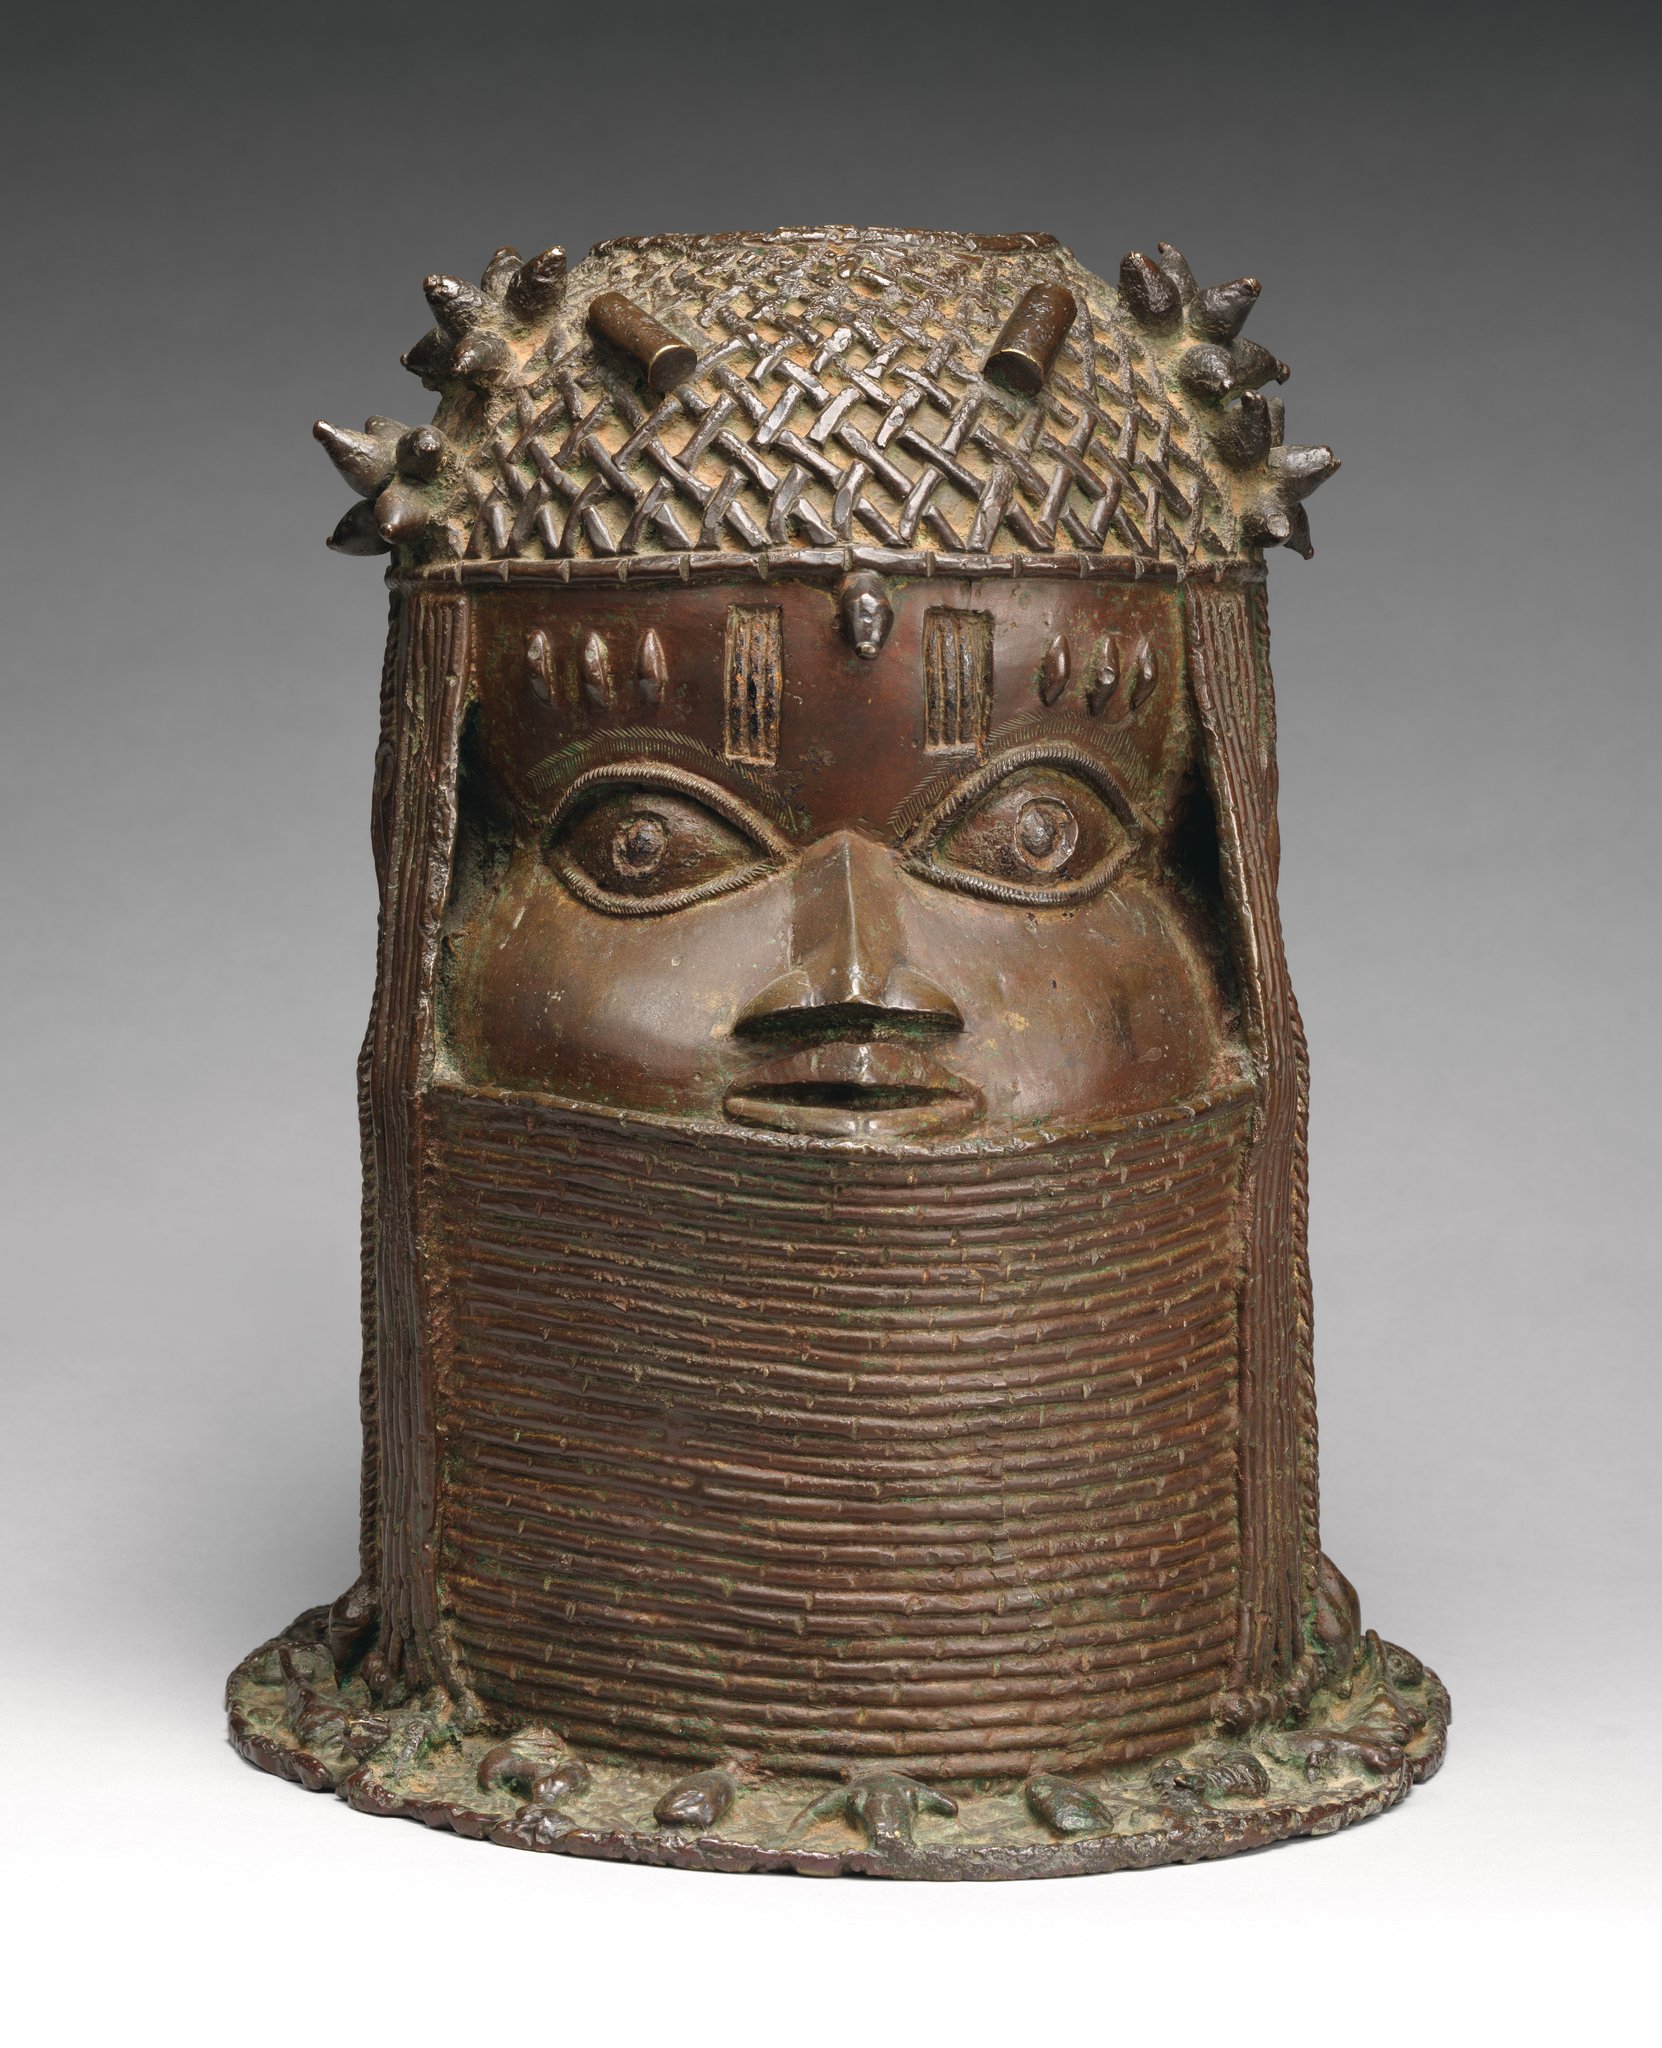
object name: head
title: Ùhúnmwèlaò (head of an ọ́bà)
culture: edo period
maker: ìgùn ẹ́rọ̀nwwọ̀n (brass-casting guild) artists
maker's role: artist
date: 1801-1900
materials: brass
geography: nigeria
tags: heads